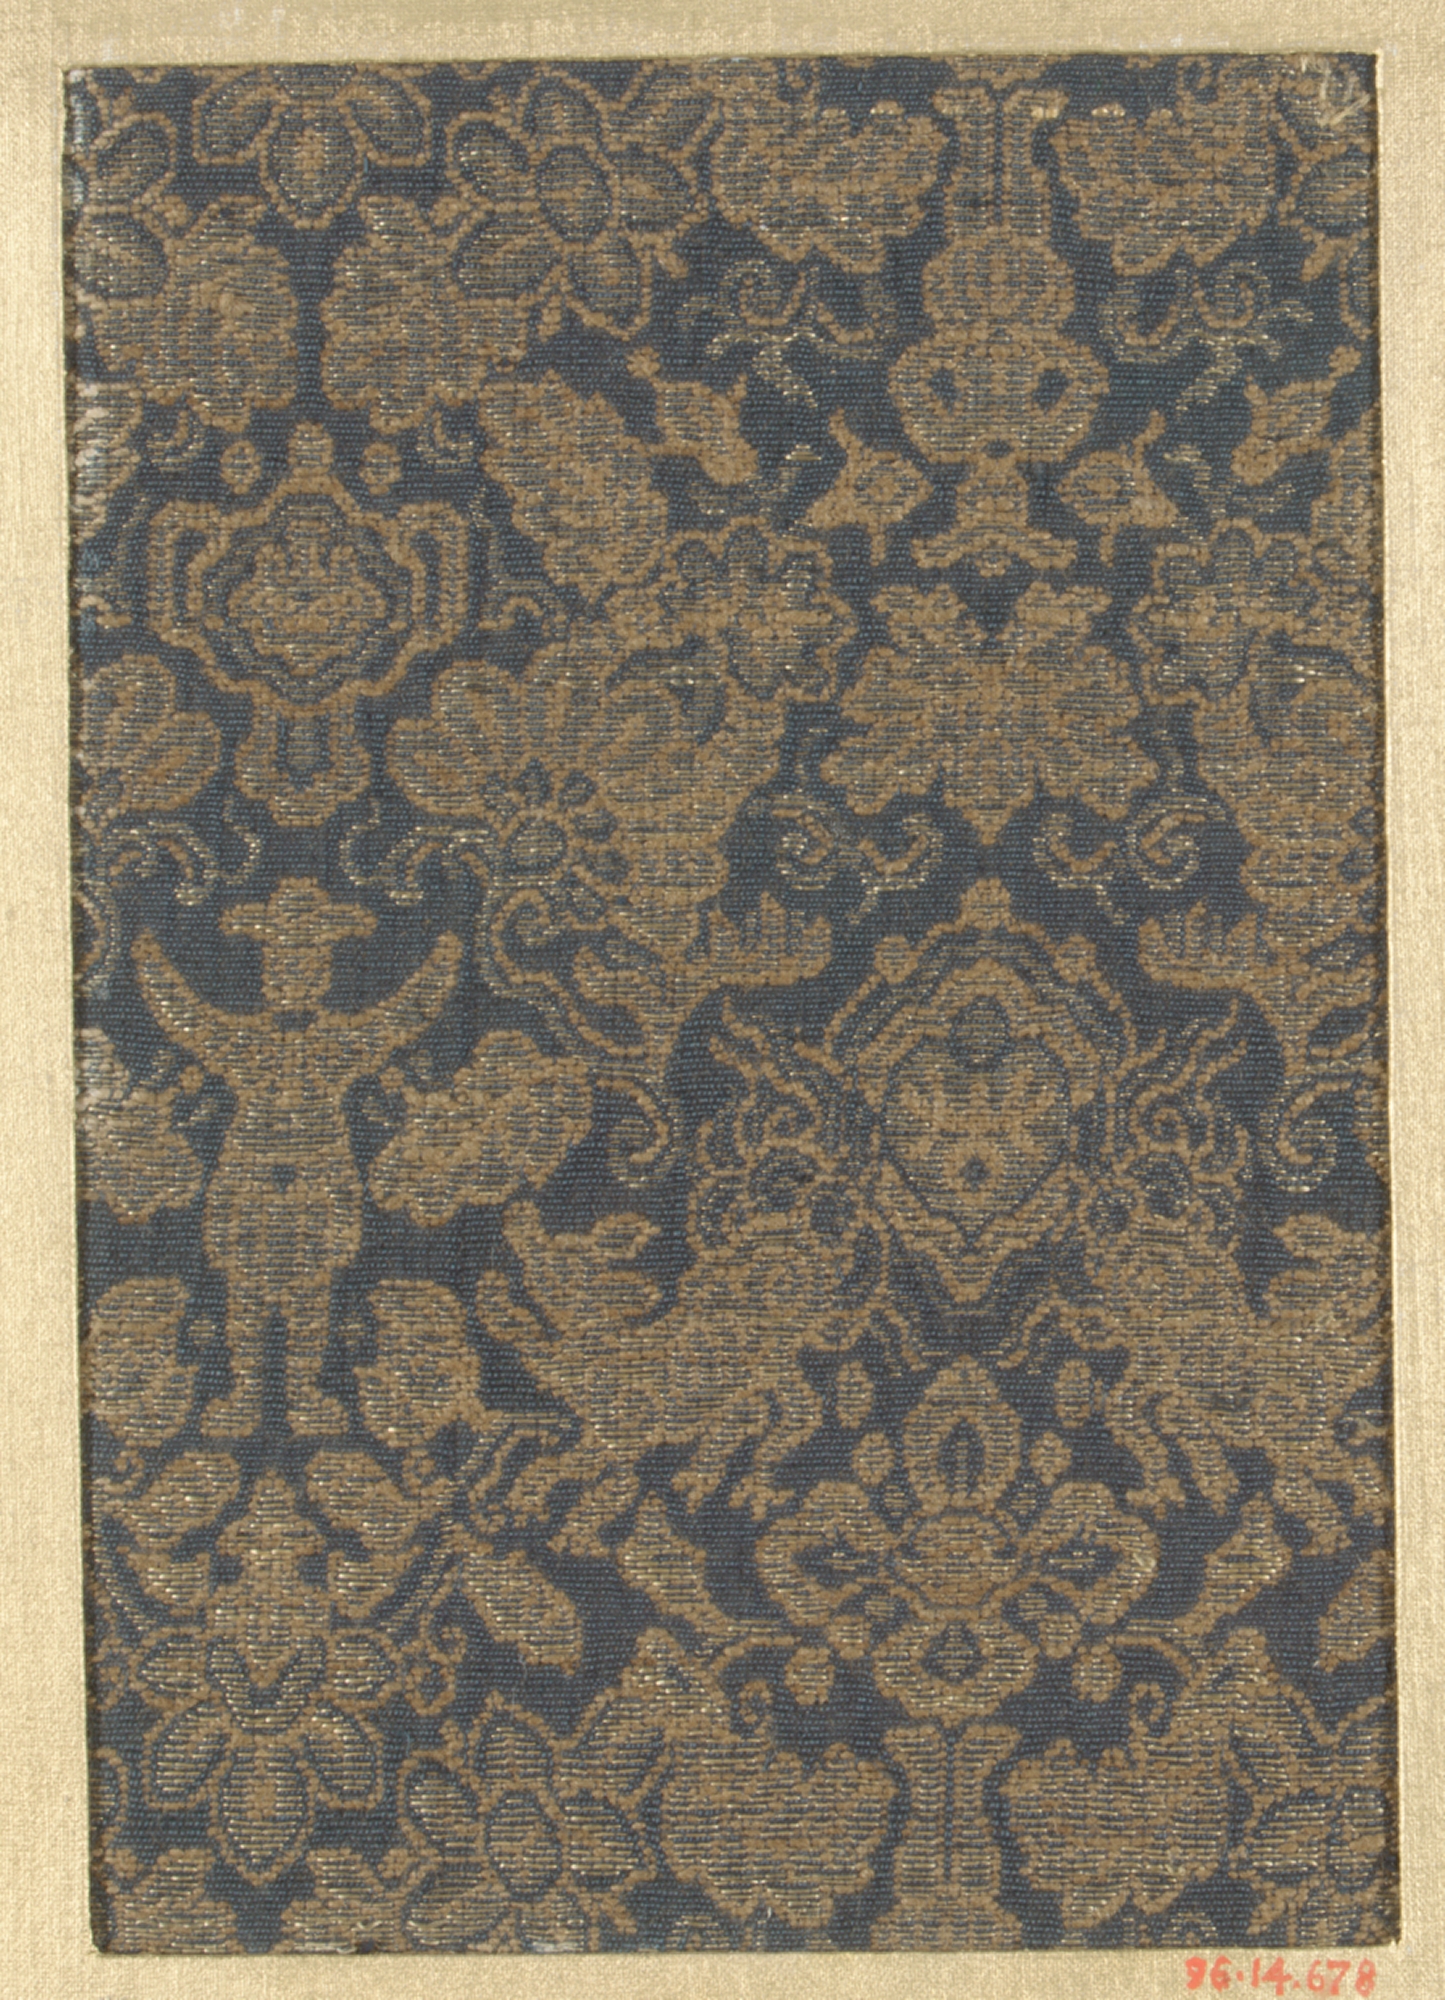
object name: piece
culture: japanese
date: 1701-1900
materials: silk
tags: human figures